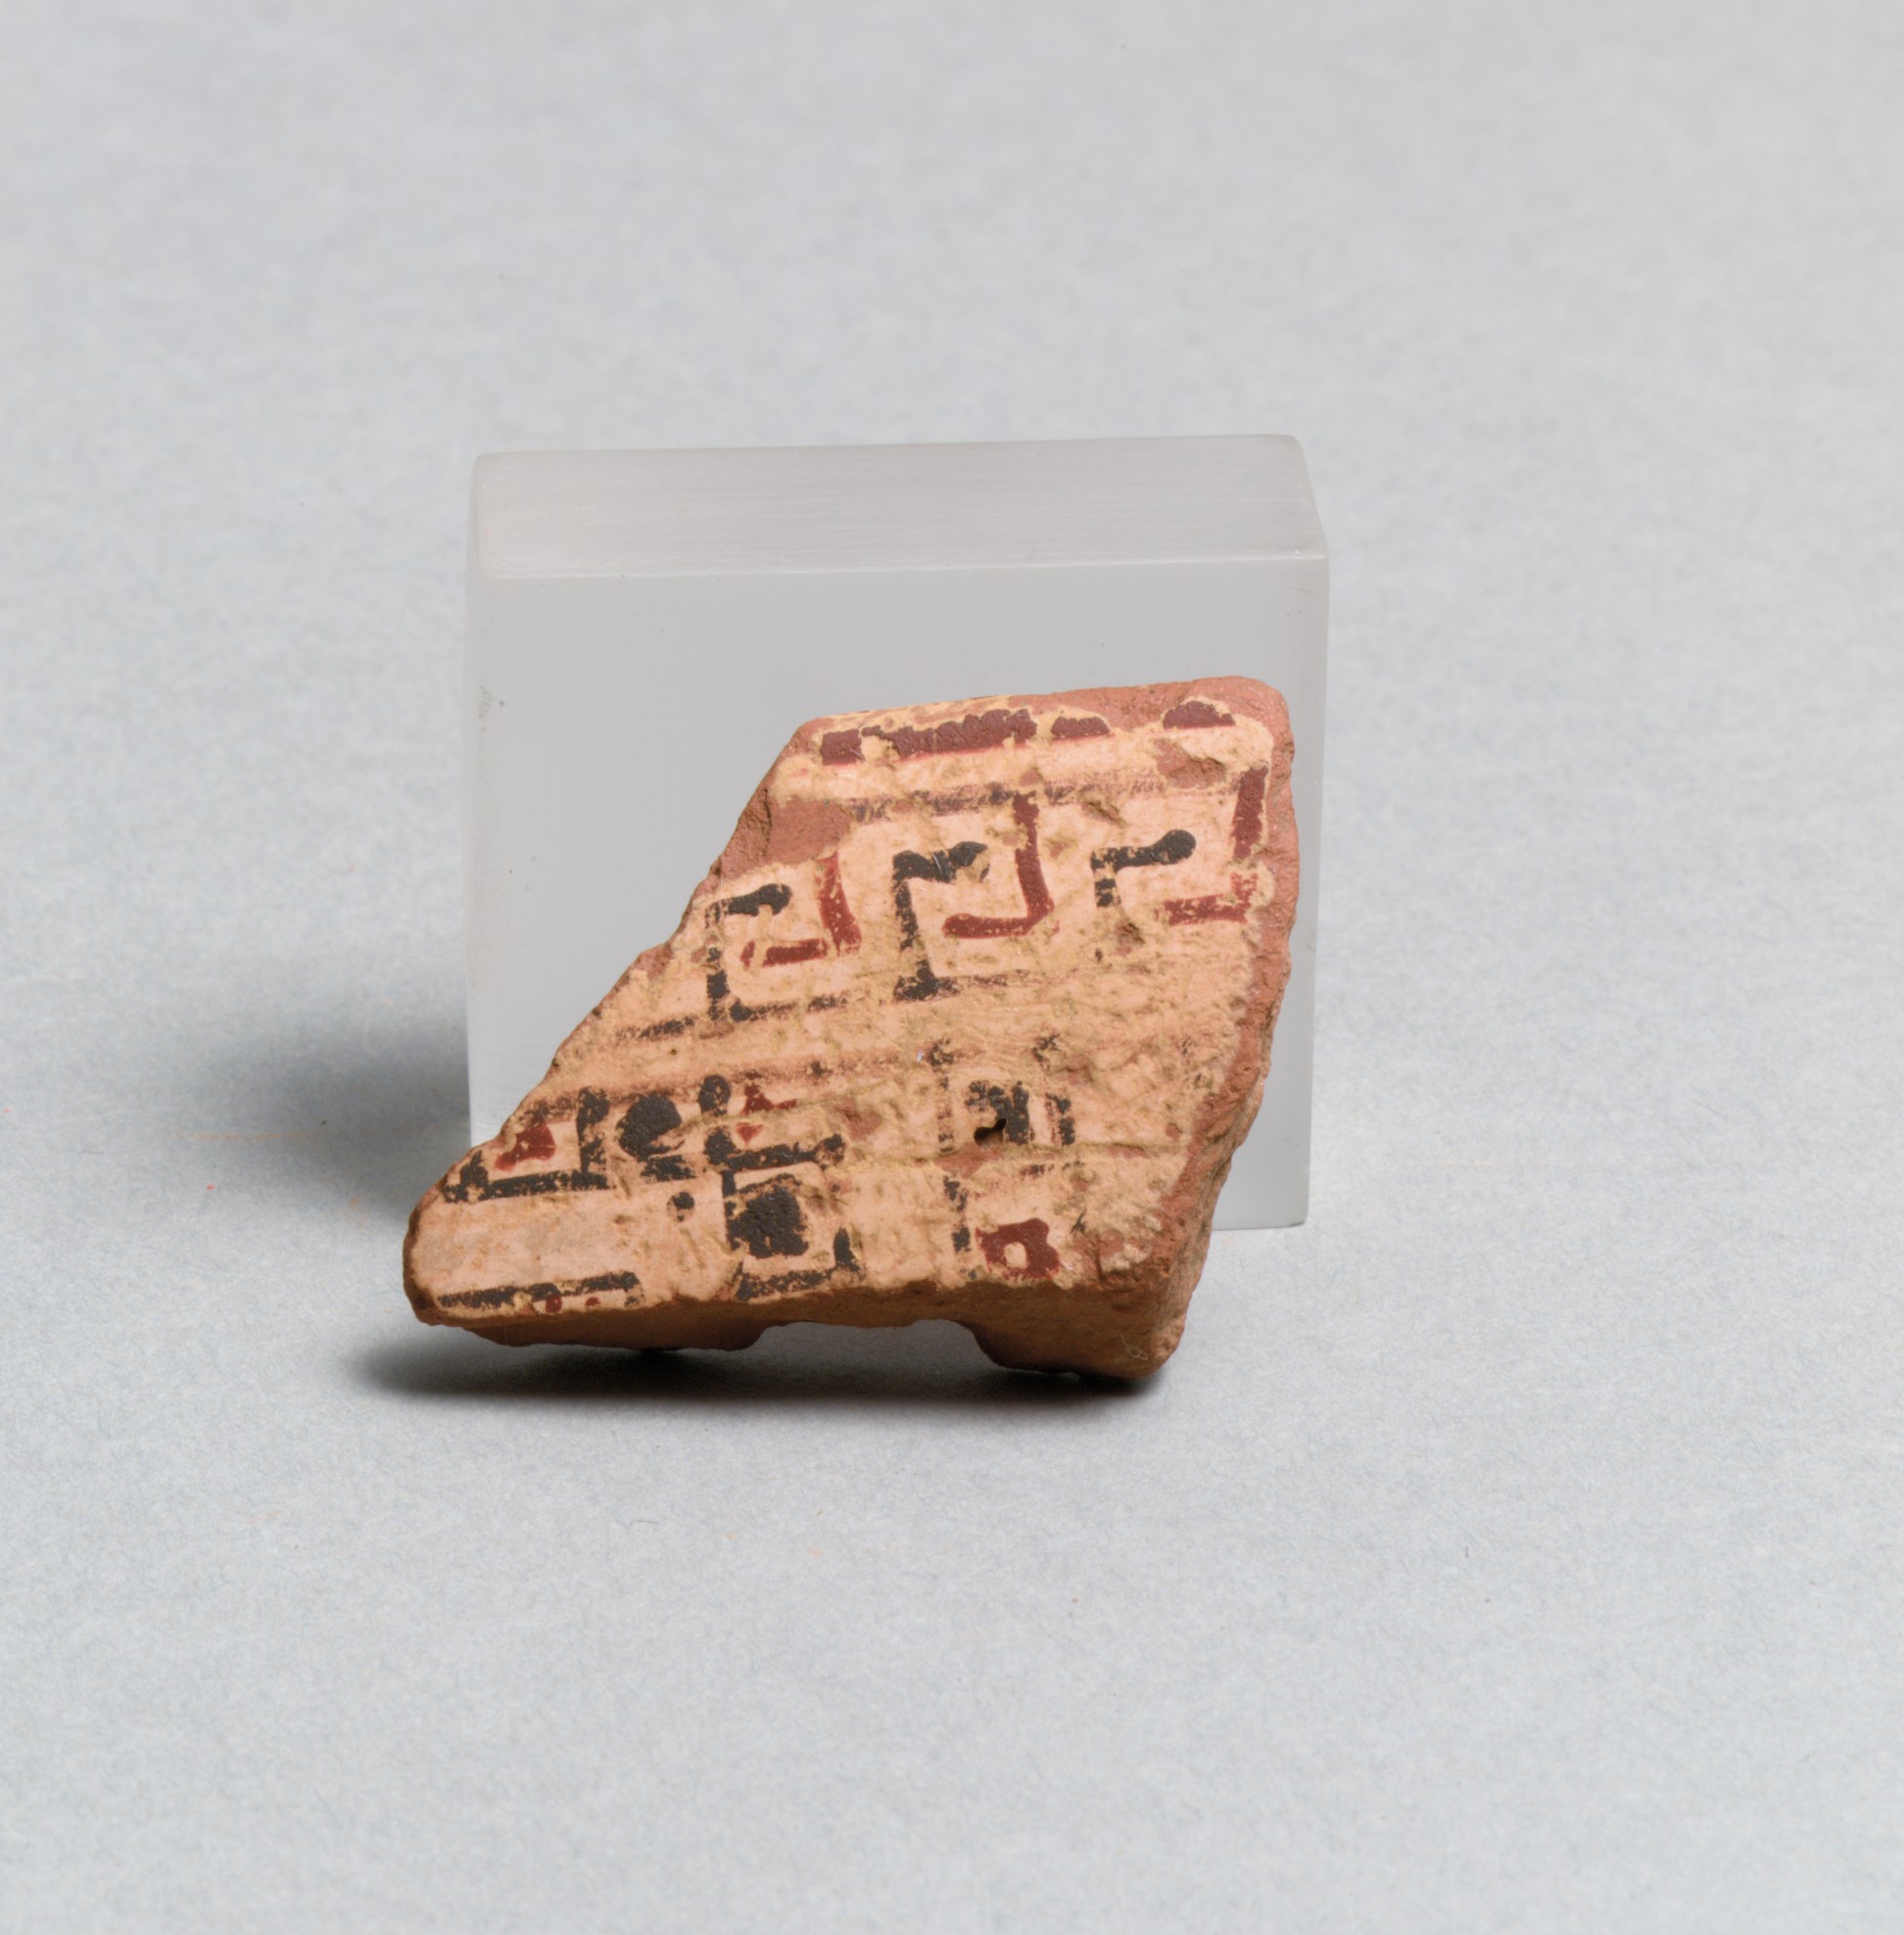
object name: vase fragment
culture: greek or lydian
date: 900-30 BCE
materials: terracotta